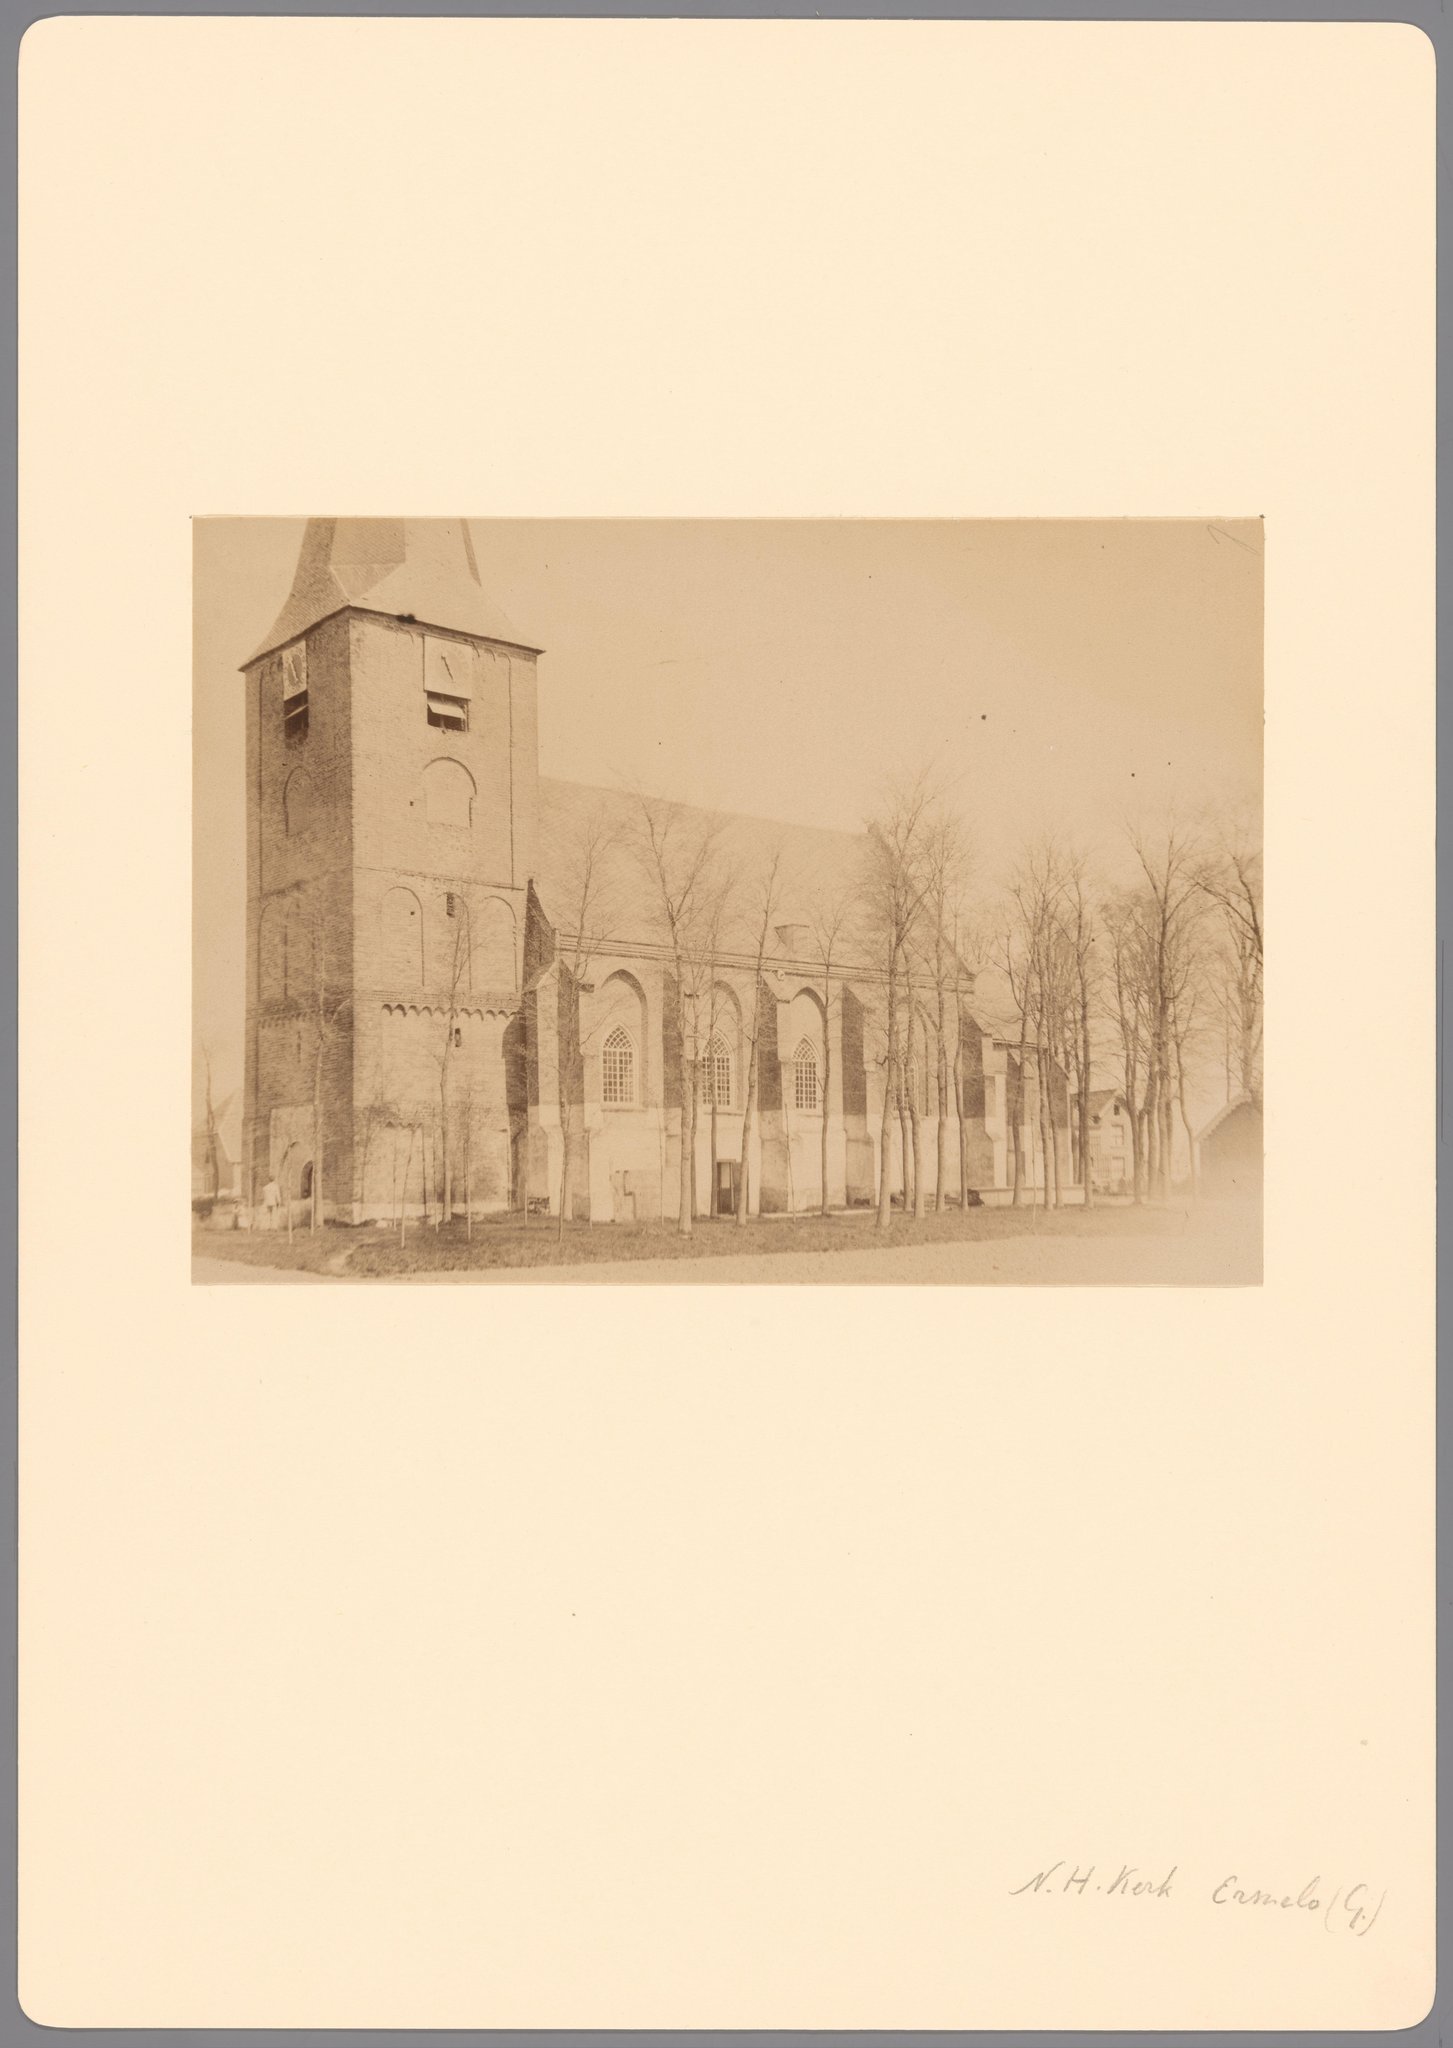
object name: photograph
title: Gezicht op de Hervormde Kerk te Ermelo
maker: anoniem (monumentenzorg)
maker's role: fotograaf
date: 1890-1920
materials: cardboard, photographic support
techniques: albumen print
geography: ermelo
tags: church (exterior)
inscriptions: annotation: ‘N.H. Kerk Ermelo (G.)’